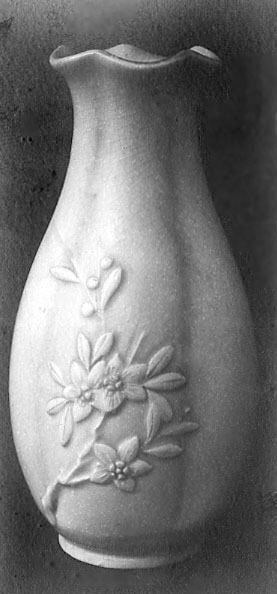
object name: vase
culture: japanese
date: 1801-1900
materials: glaze